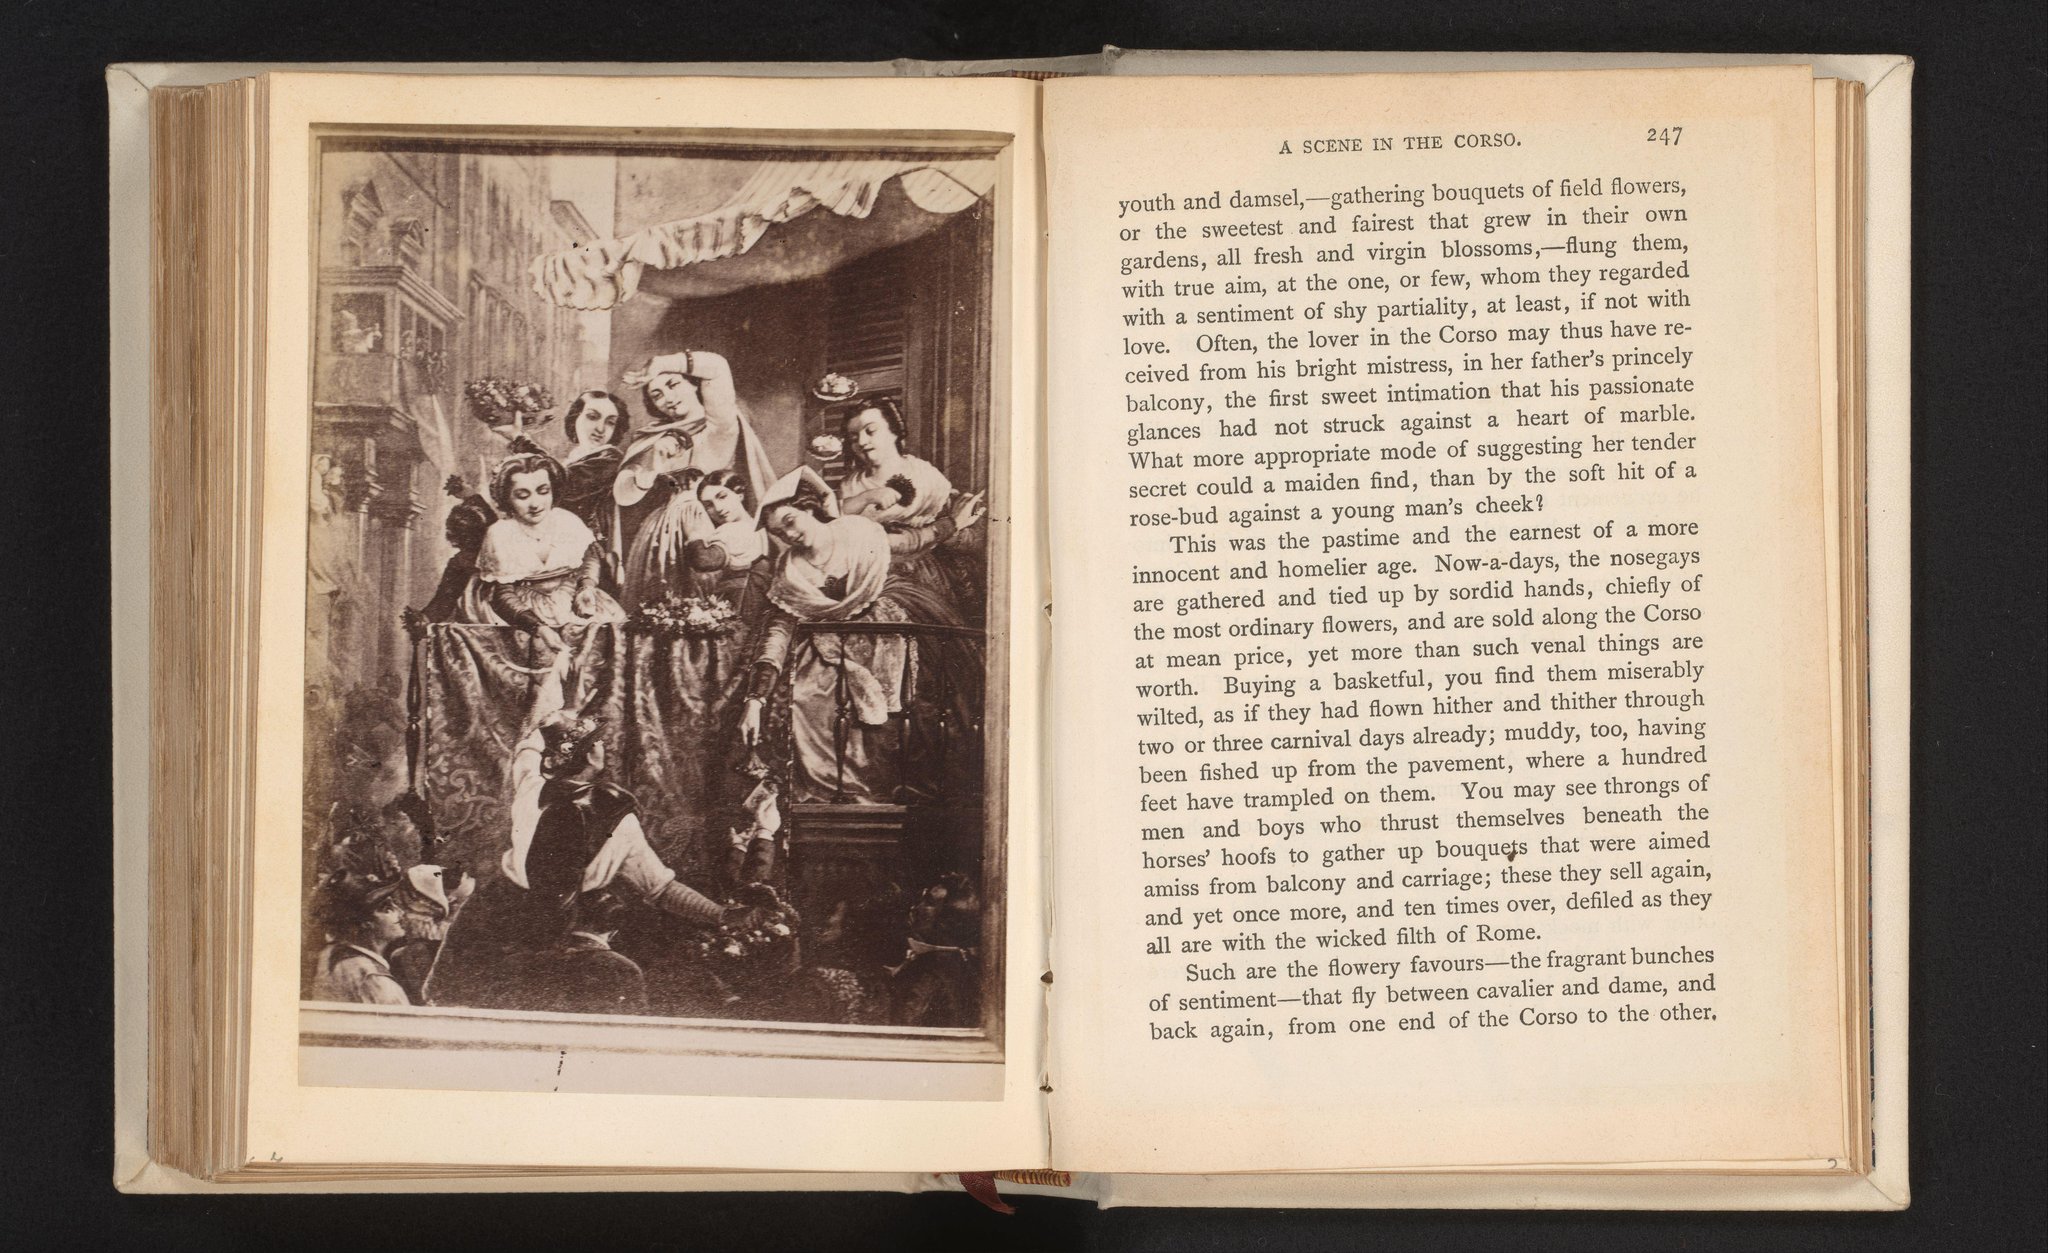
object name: page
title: Fotoreproductie van een tekening van carnaval met vrouwen op een balkon met bloemen aan de Via del Corso in Rome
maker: Anonymous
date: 1850-1860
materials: photographic support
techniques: albumen print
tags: periodic celebrations, popular feasts